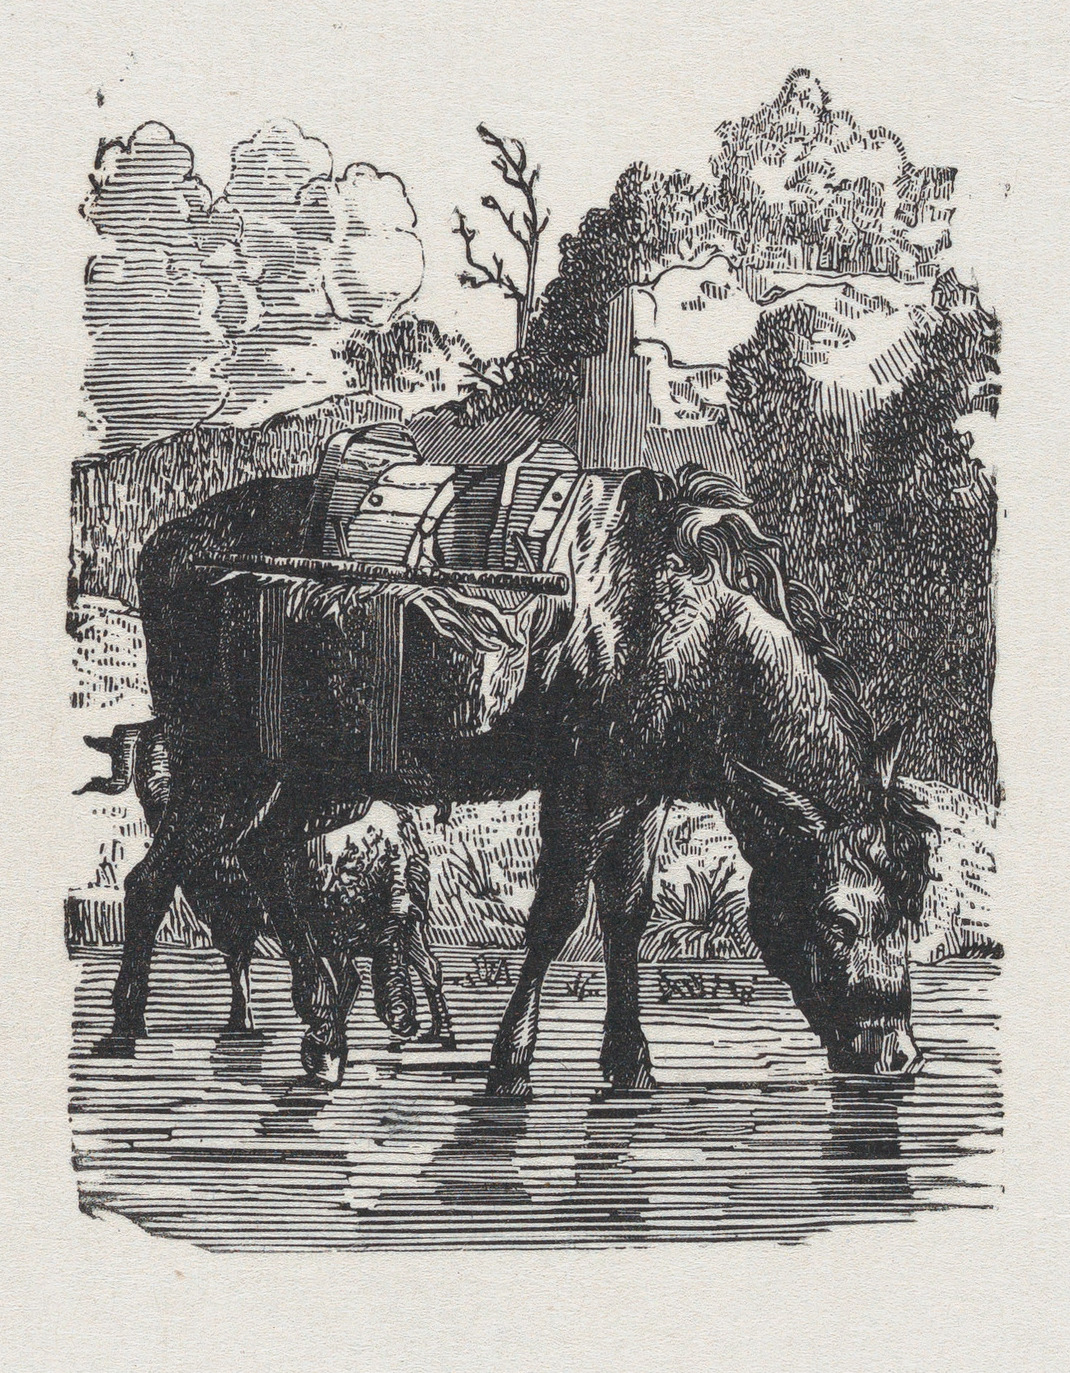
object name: print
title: Saddled donkeys drinking water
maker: anonymous, mexican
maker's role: artist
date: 1801-1900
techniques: engraving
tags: donkeys